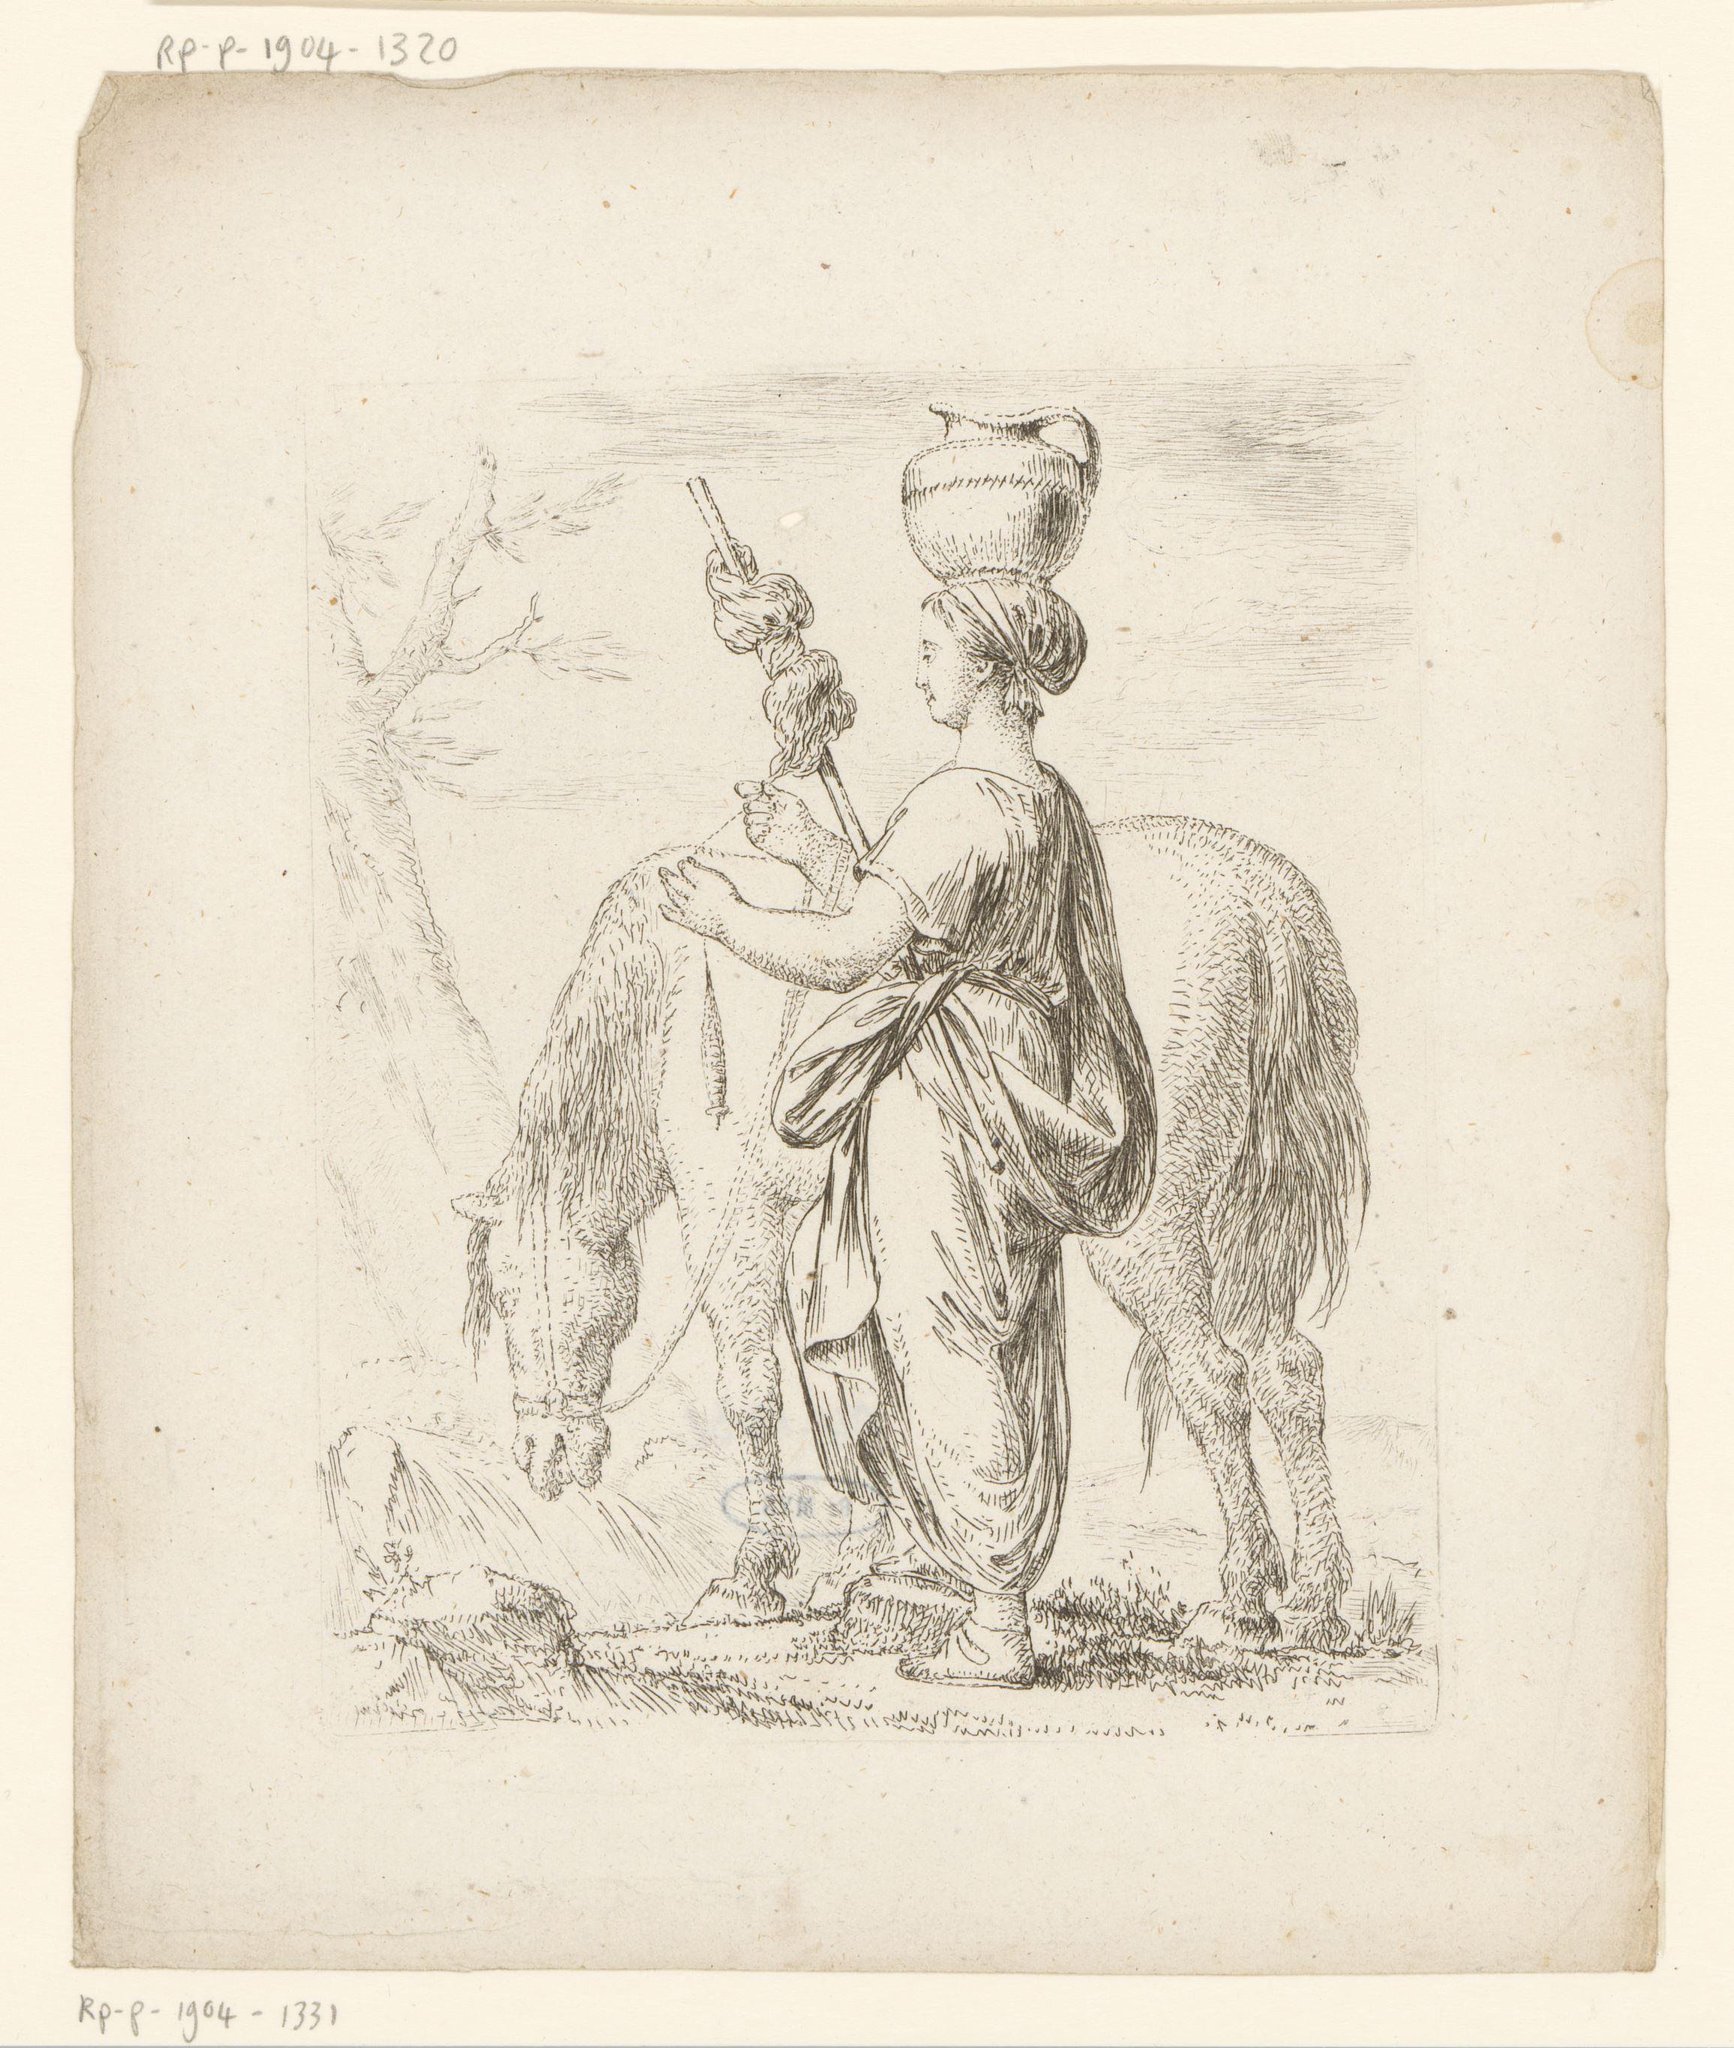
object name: print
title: Allegorie van de ijver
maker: bernhard rode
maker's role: artist, print maker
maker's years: 1725-1797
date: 1788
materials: paper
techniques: etching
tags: zelus, zeal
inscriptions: collector's mark: Lugt 2228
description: Prent ook gebruikt in: Ramler, Karl Wilhelm. Allegorische Personen zum Gebrauche der bildenden Künstler. Berlijn: Akademischen Kunst- und Buchhandlung, 1788.